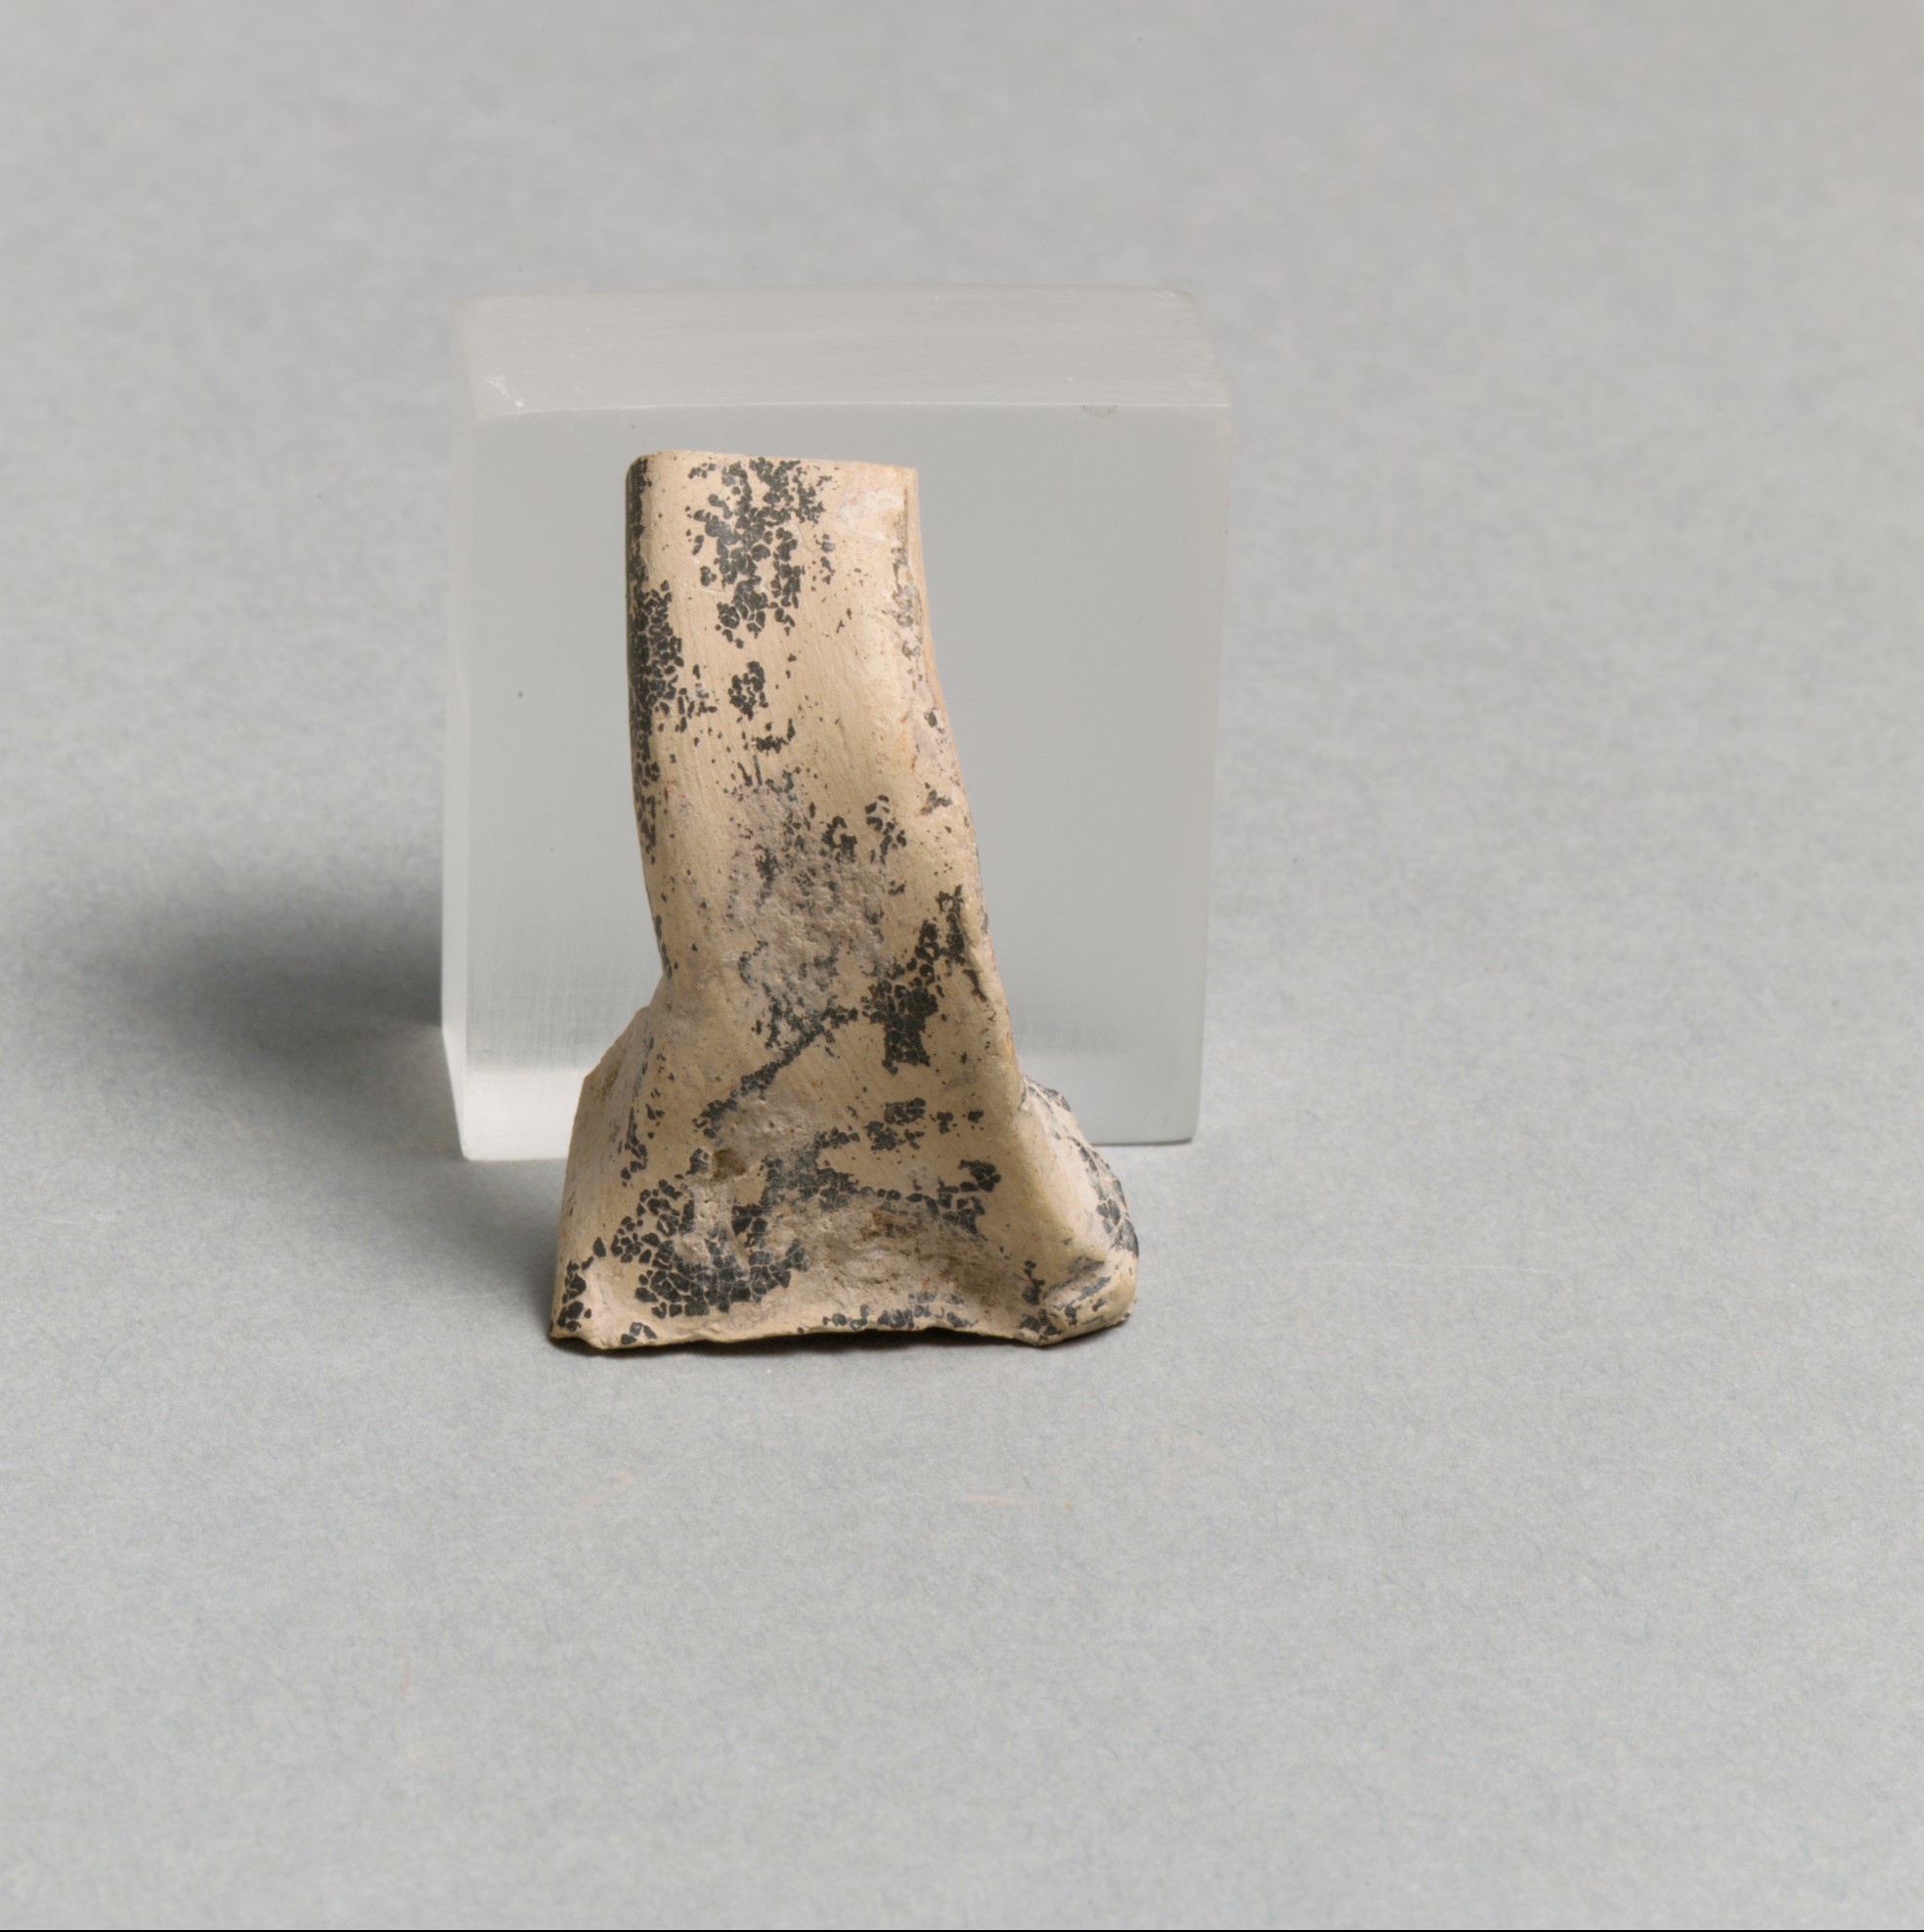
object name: vase fragment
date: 3000-2200 BCE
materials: terracotta